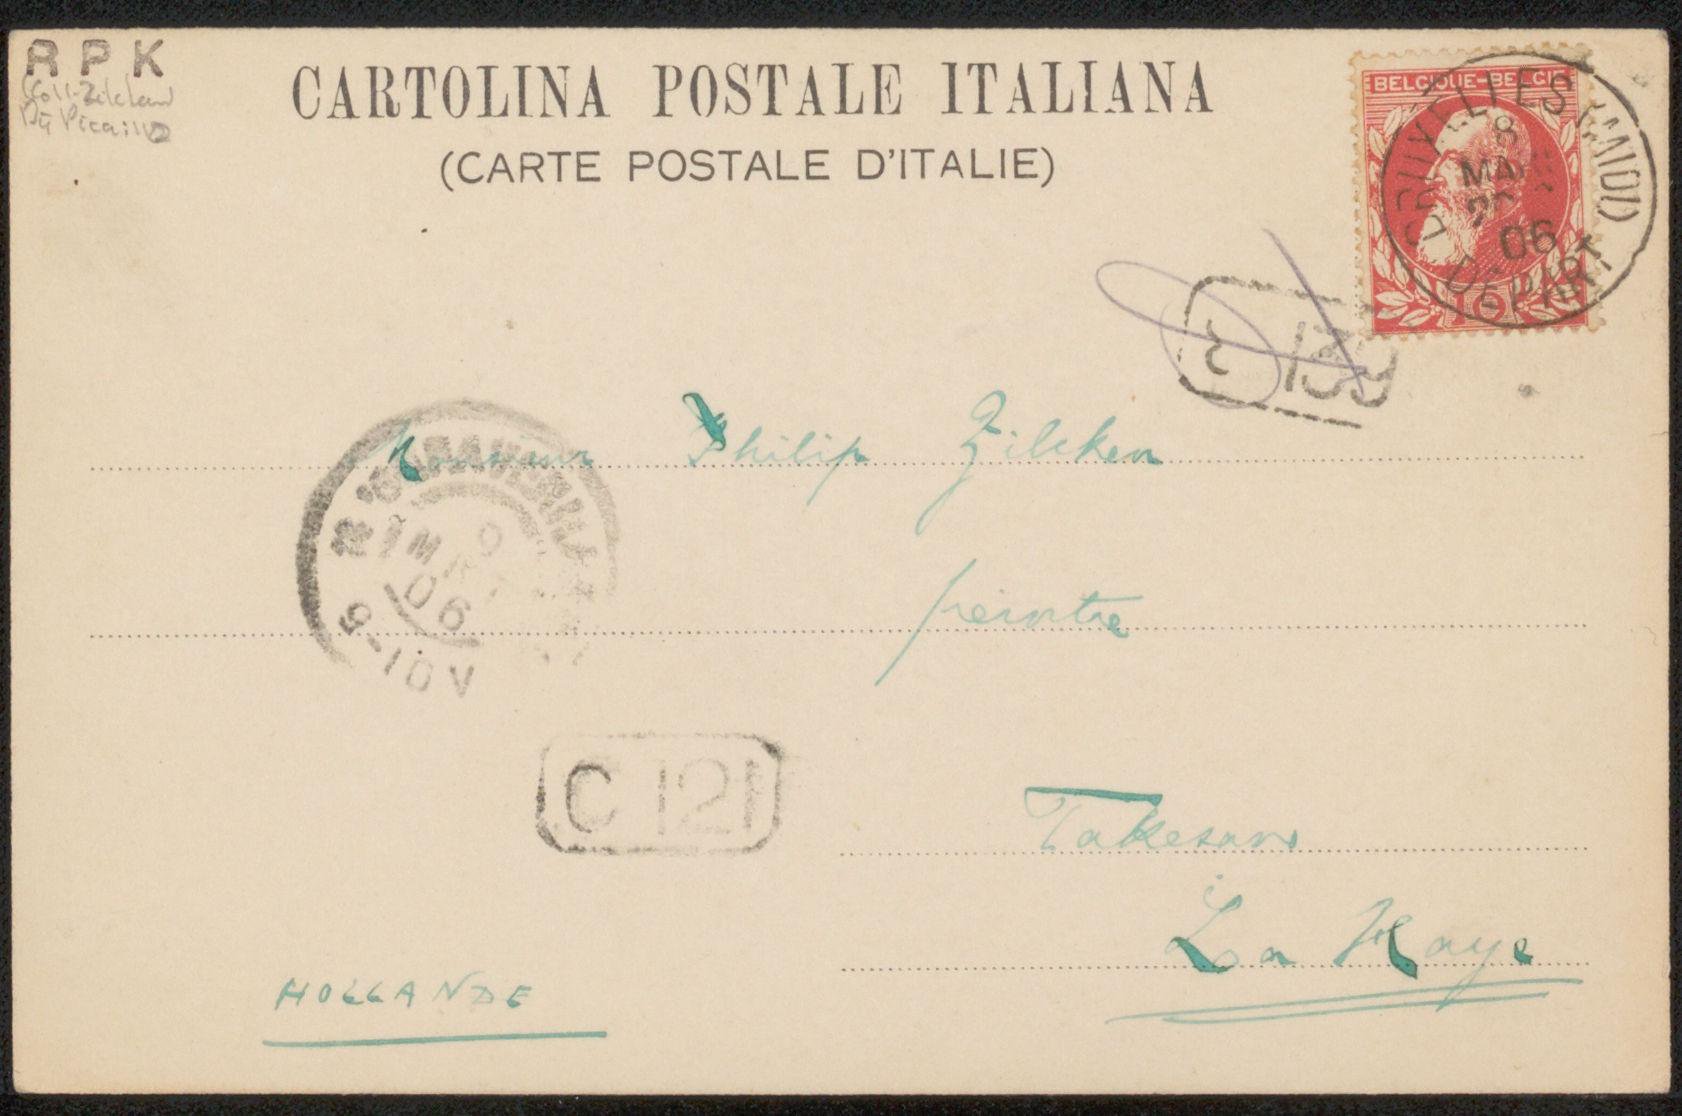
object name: postcard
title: Briefkaart aan Philip Zilcken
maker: vittorio pica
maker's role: criticus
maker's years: 1864-1930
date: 1906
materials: cardboard, ink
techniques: pen, printing, writing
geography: brussels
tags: jan toorop, the hague, painter, philip zilcken, the graphic arts, painting (including book-illumination, miniature-painting), exhibition ~ art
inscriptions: collector's mark: ‘RPK’